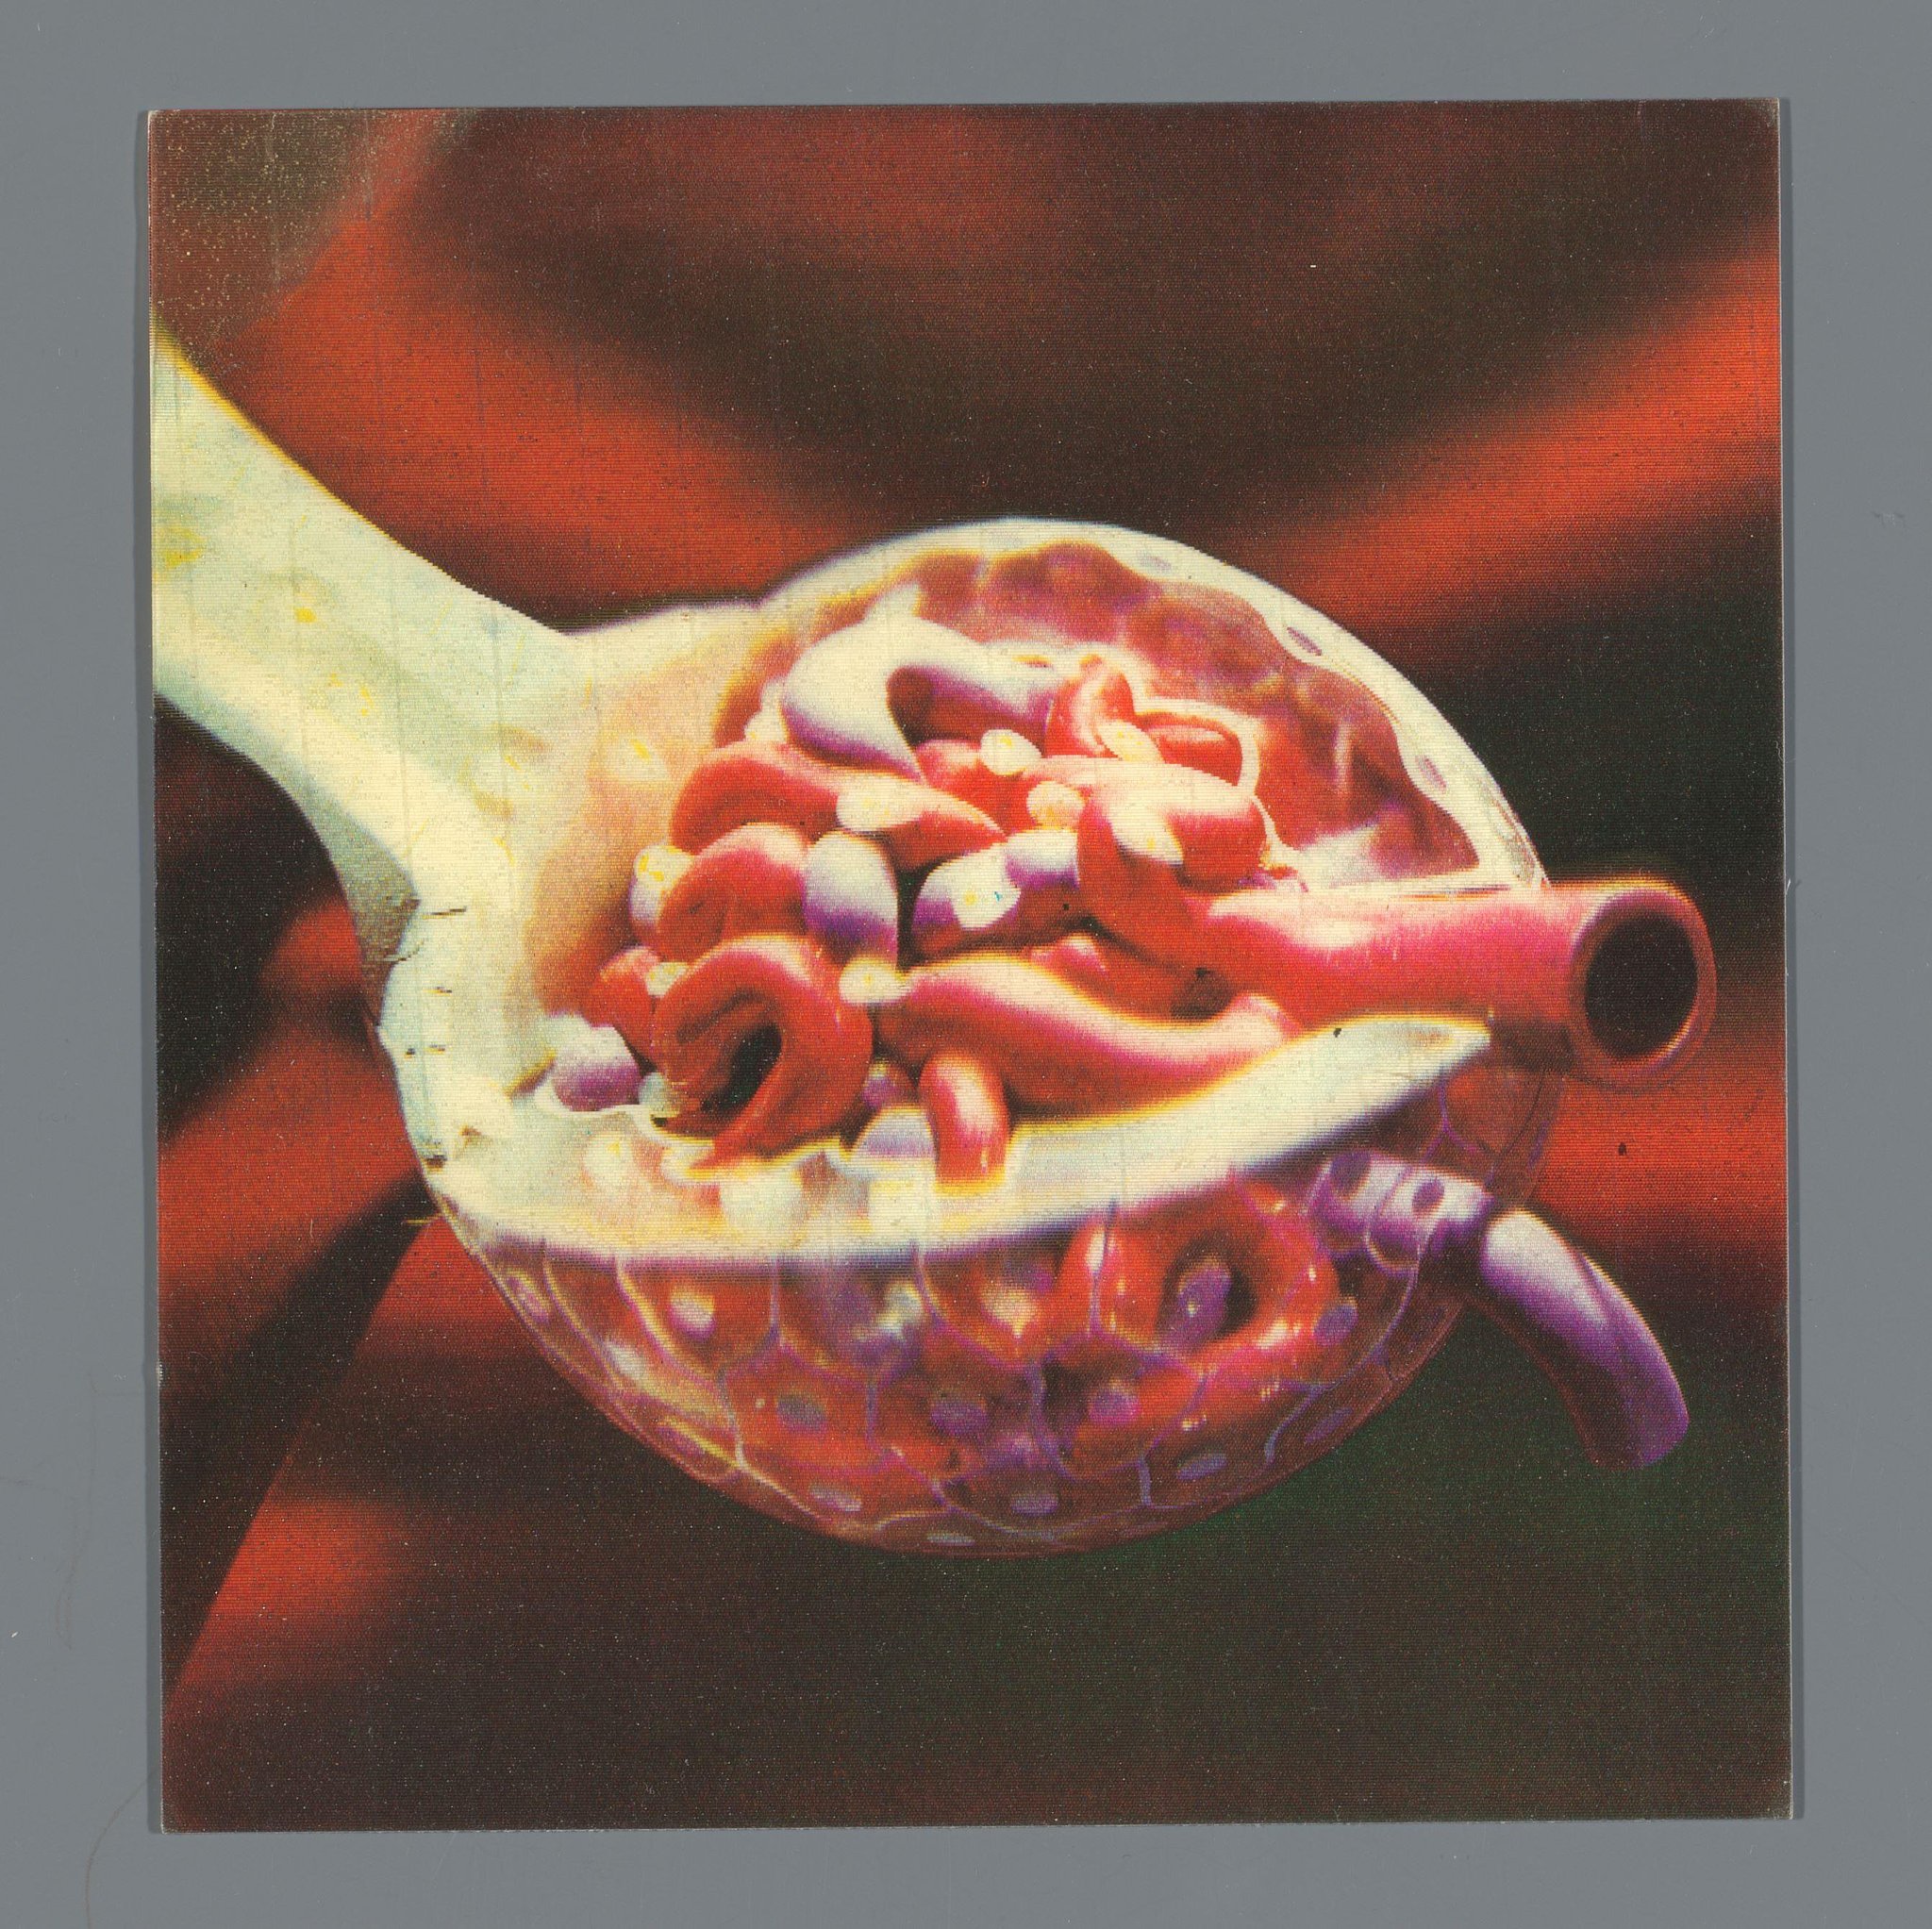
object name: photomechanical print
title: Model van het kapsel van Bowman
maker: Anonymous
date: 1960-1984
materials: paper, plastic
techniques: offset printed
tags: kidney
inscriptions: inscription: ‘This striking three-dimensional representation of Bowman's/ capsule illustrates the high glomerular filtration rate of/ Terramycin (oxytetracycline). Unique in pharmacologic/ activity among the four tetracycline analogues, oxytetracy-/ cline has the highest 96-hour urinary recovery rate, the/ lowest protein binding, and the highest relative diffusionnate./ A three-dimensional sculptural rendition of Bowman's/ capsule was used for photographic purposes./ Science for the world's well-being/ Pfizer Since 1849/ PFIZER LABORATORY Division. Chas, Pfizer & Co., Inc. New York, New York 10017/ XOGRAPHY’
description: Lenticulaire druk van een model van het kapsel van Bowman ter promotie van het middel Terramycin geproduceerd door Pfizer.